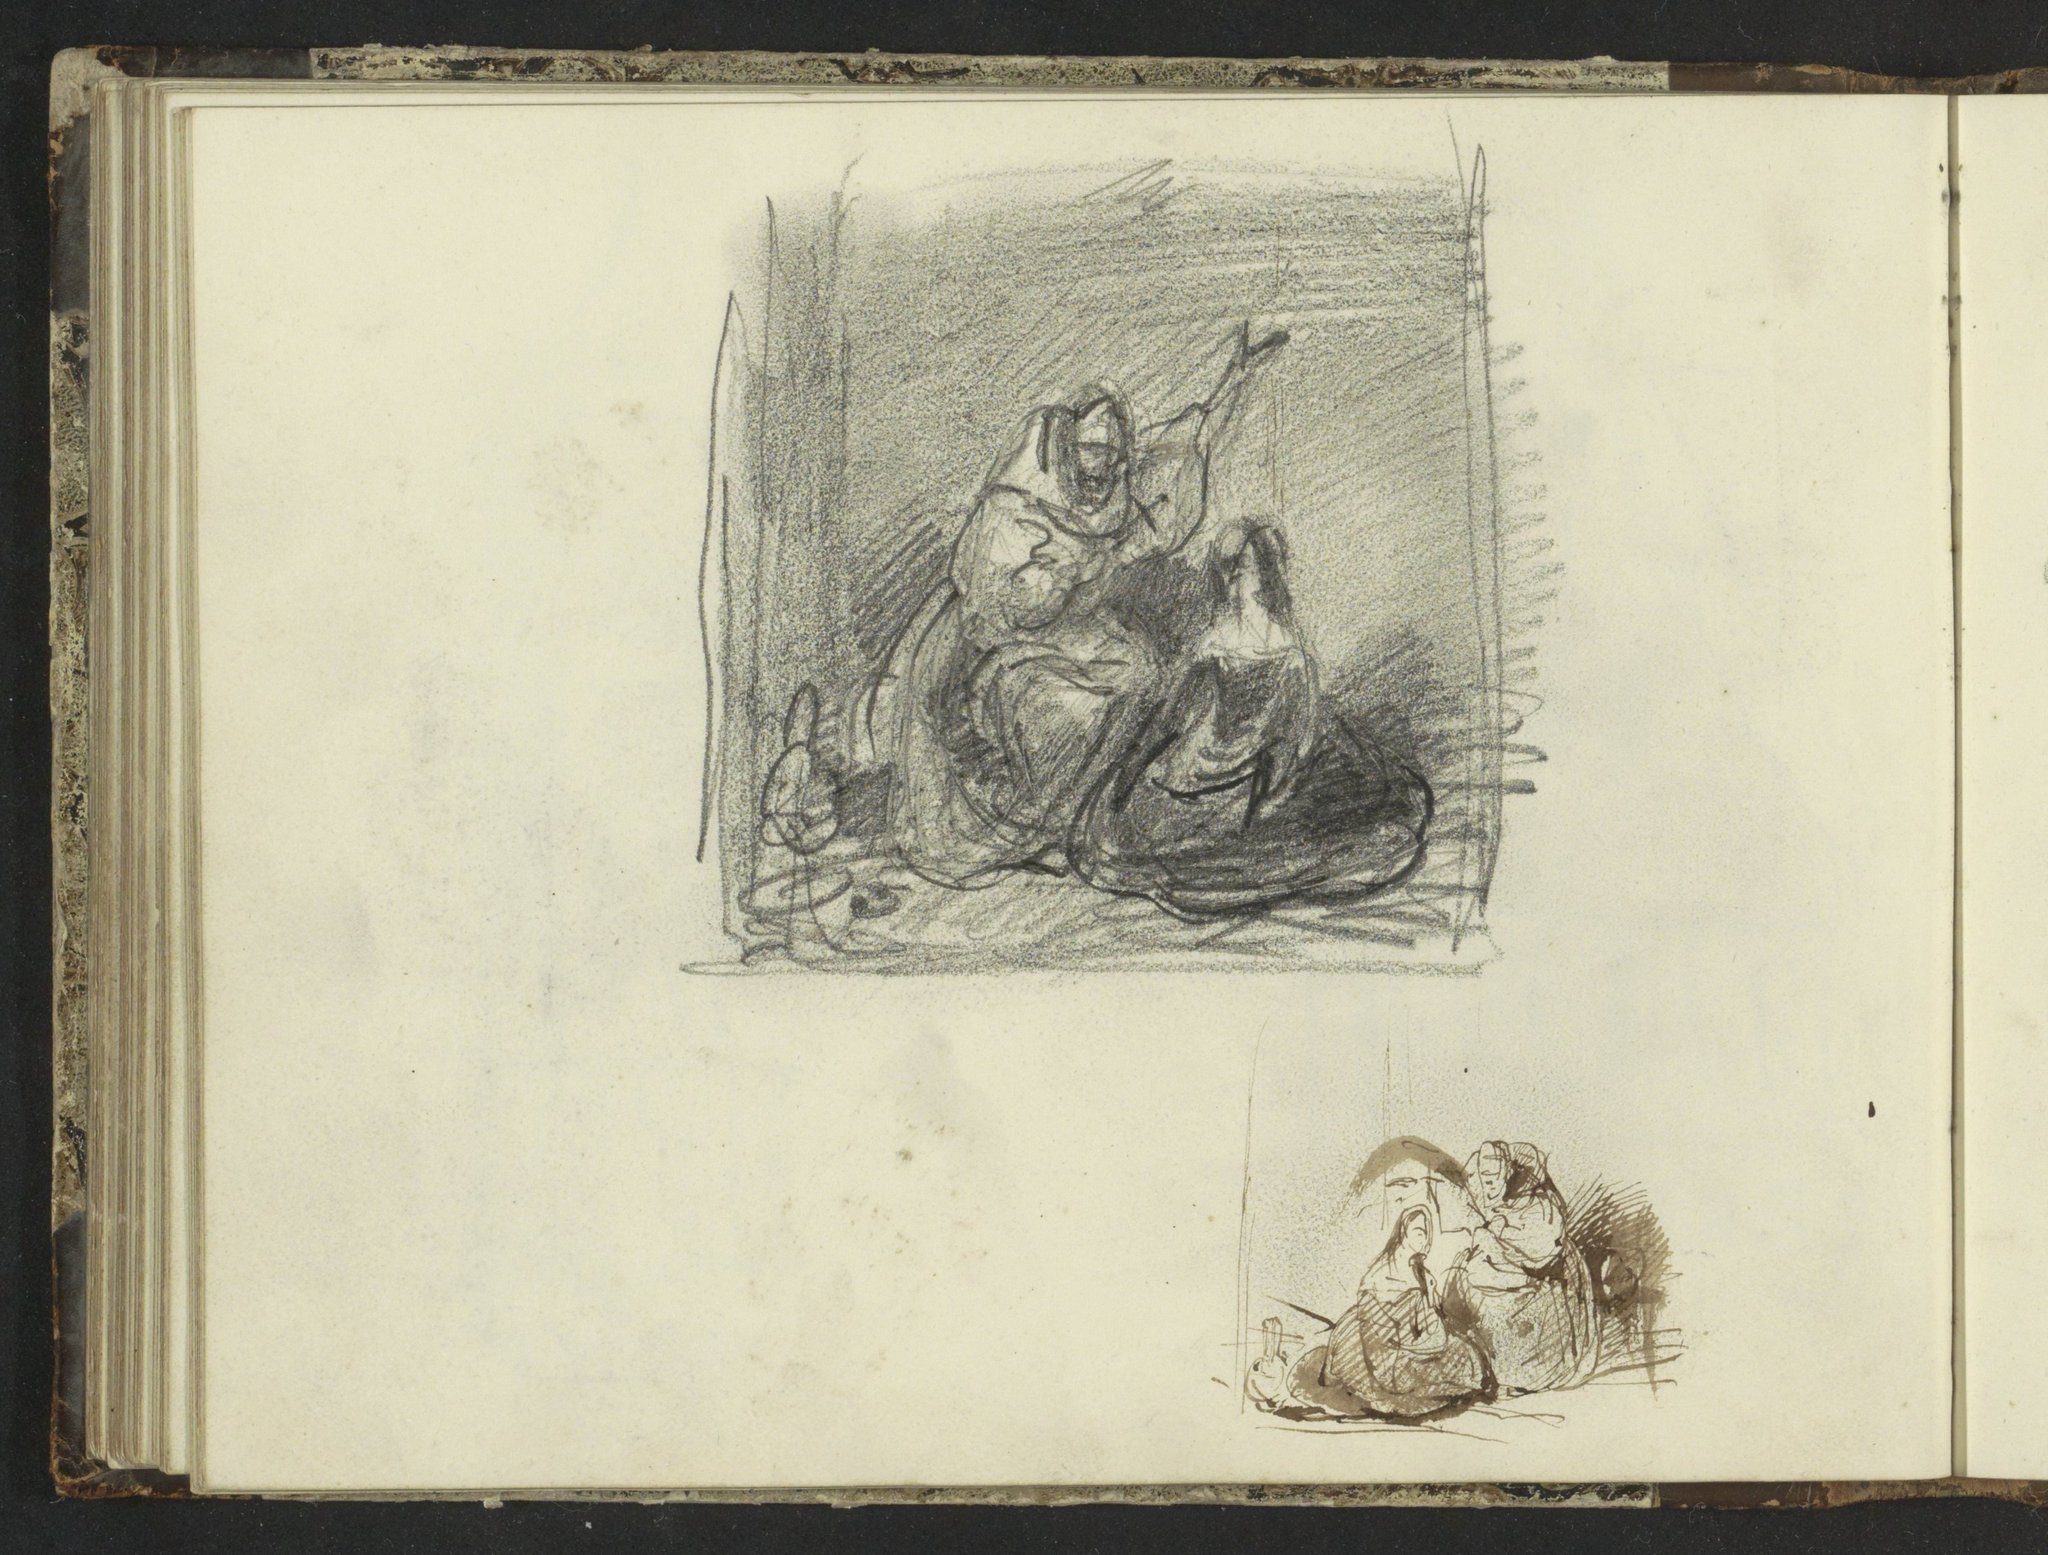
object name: sketchbook leaf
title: Interieur met een monnik en zittende vrouw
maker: willem hendrik schmidt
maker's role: draughtsman, painter, print maker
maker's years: 1809-1849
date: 1819-1849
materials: ink, paper, pencil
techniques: pen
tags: monk(s), friar(s), interior of the house, kneeling figure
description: De monnik knielt bij de vrouw en houdt zijn linkerhand in de lucht. Tevens een studie van twee zittende figuren, mogelijk nonnen, in een interieur. Blad 37 verso uit een schetsboek met 58 bladen.